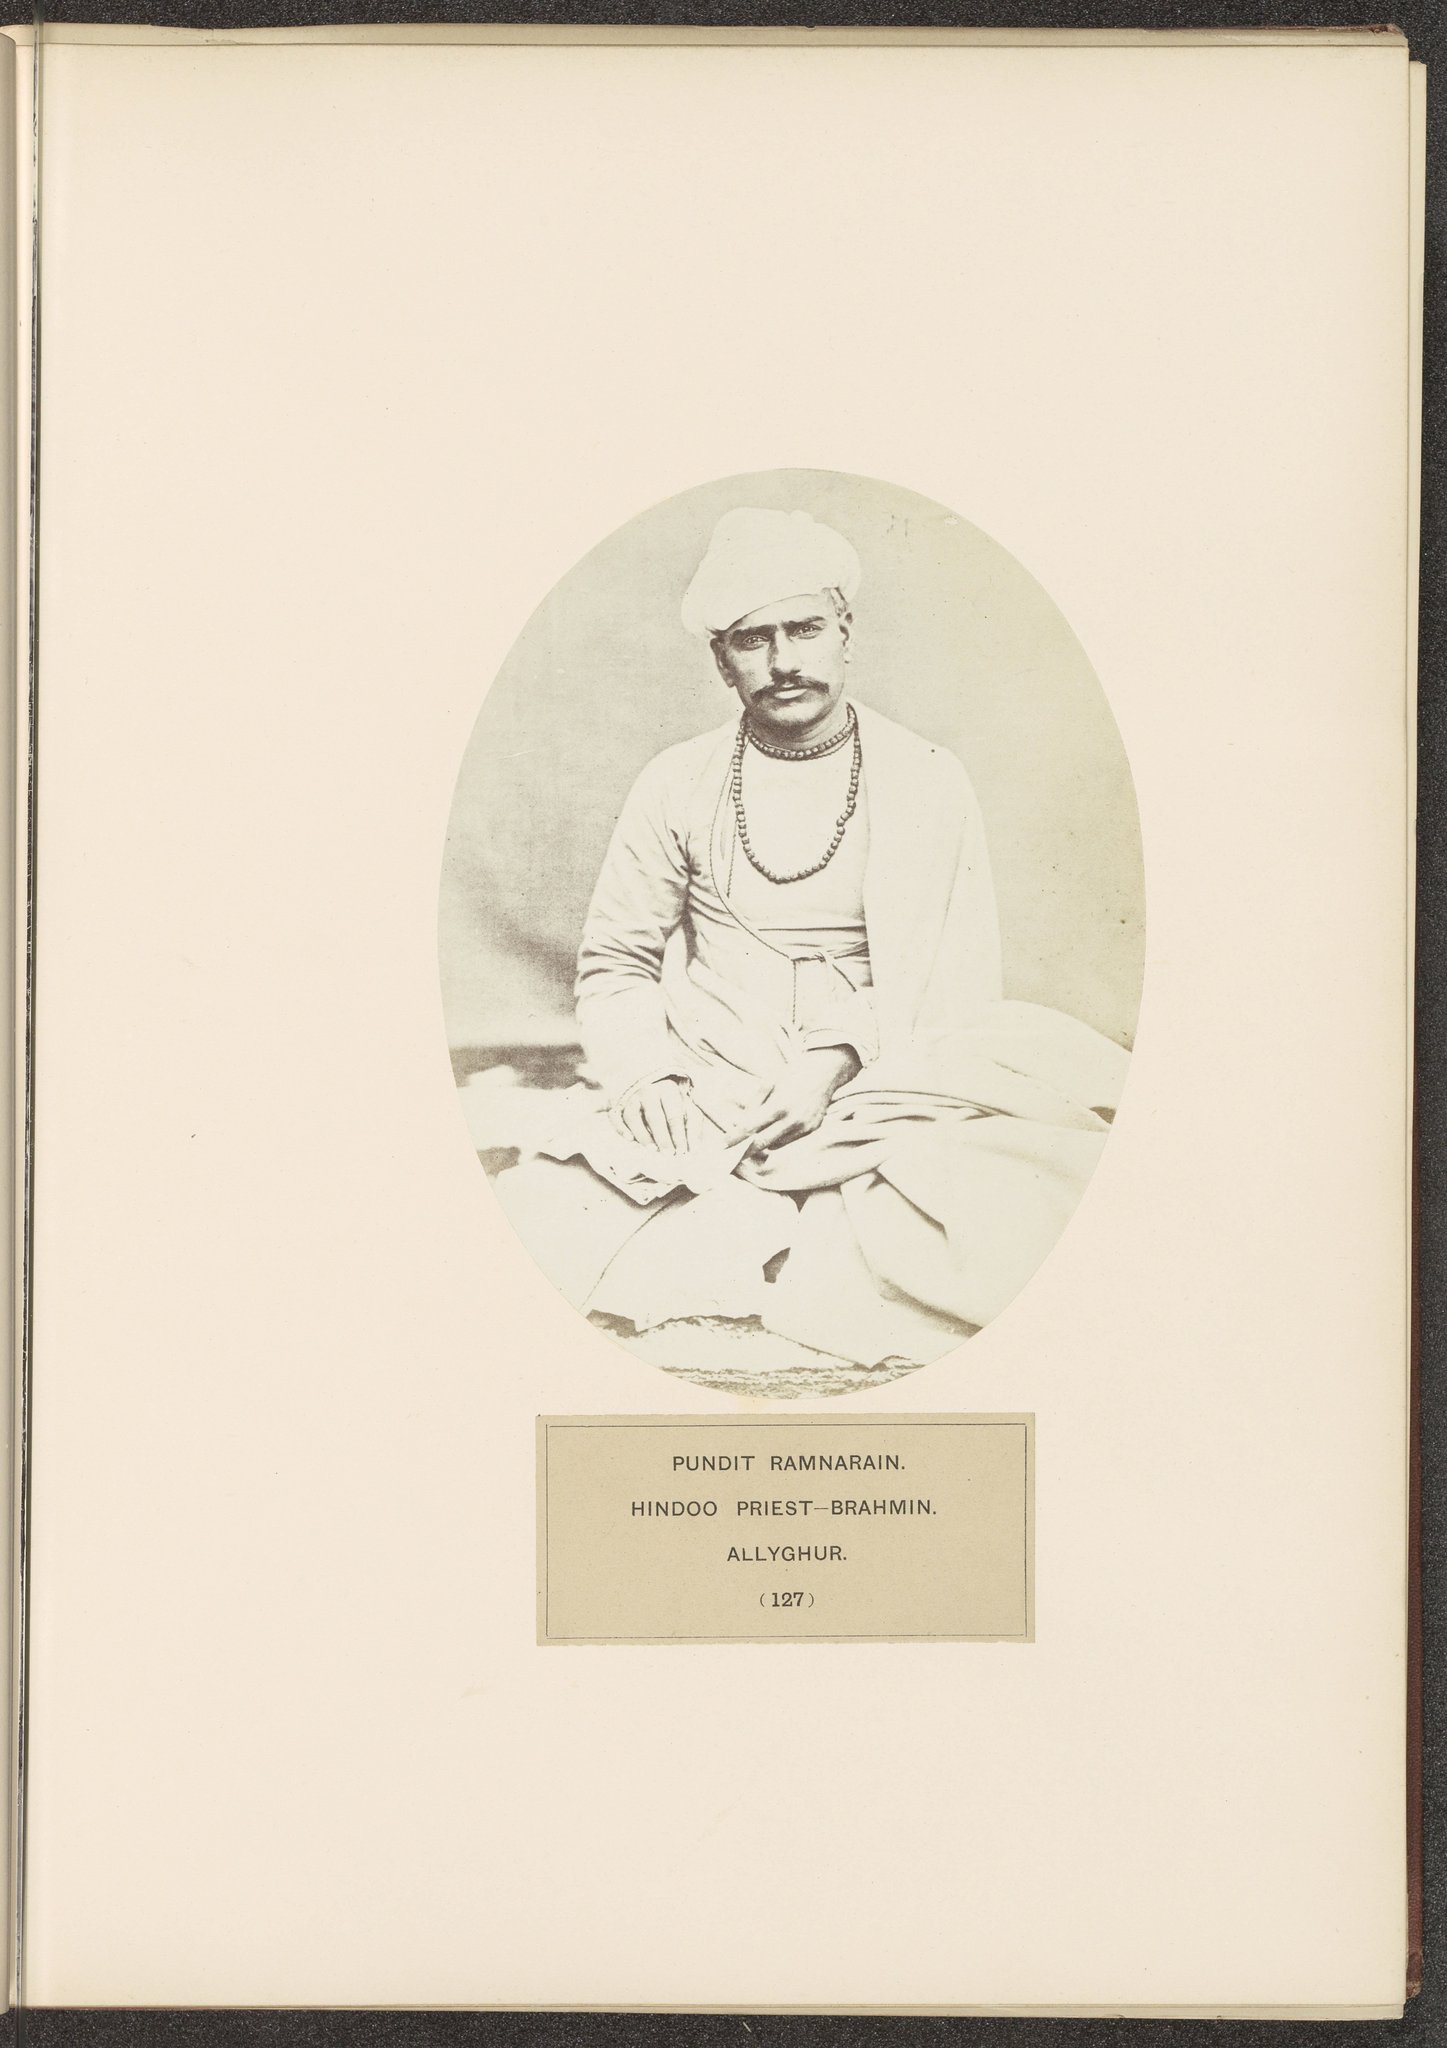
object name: page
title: Portrait of a brahmin (Hindu priest) Pundit Ramnarain from Aligarh, Uttar Pradesh, India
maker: Anonymous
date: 1858-1868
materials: photographic support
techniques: albumen print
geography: aligarh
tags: priest ~ hinduism, buddhism, jainism, human races; peoples; nationalities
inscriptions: number: ‘(127)’, inscription: ‘PUNDIT RAMNARAIN./ HINDOO PRIEST-BRAHMIN./ ALLYGHUR.’